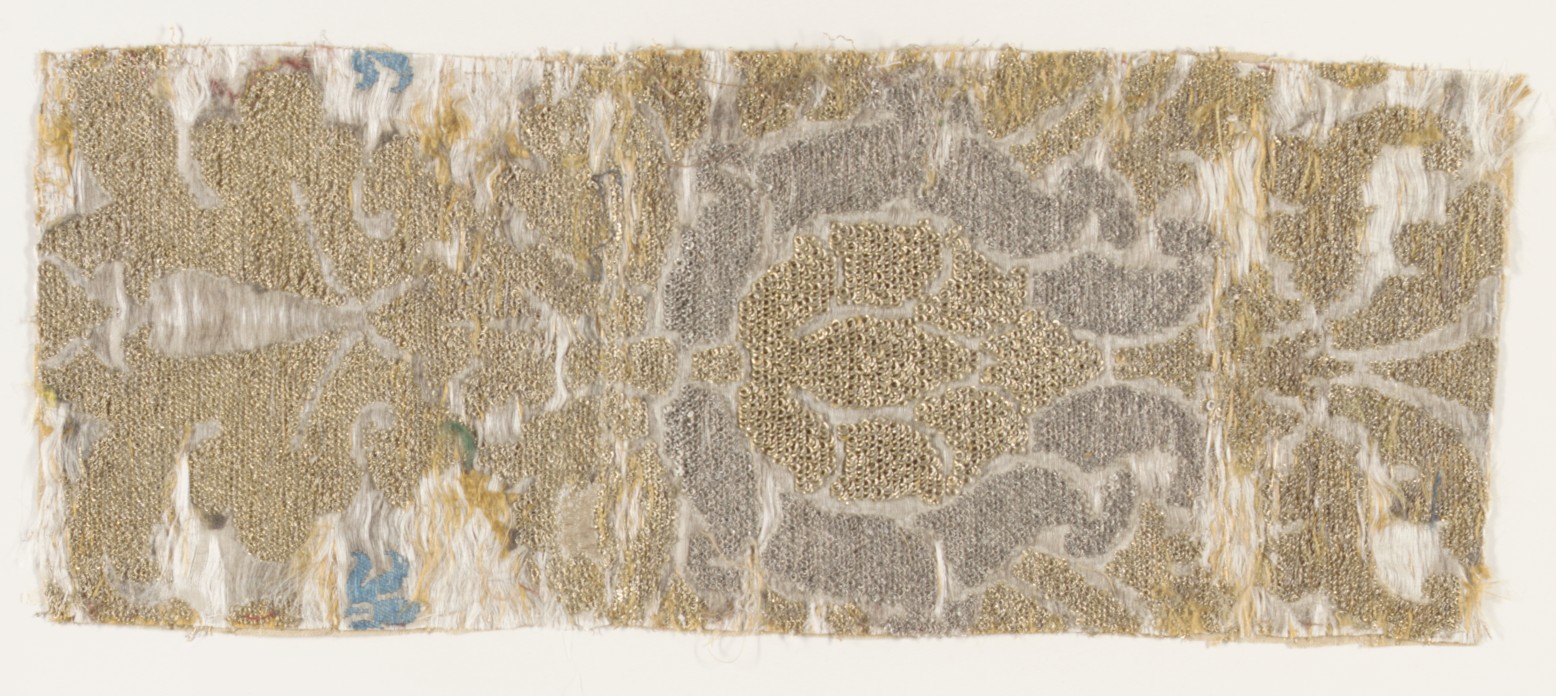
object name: fragment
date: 1401-1600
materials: metal thread, silk